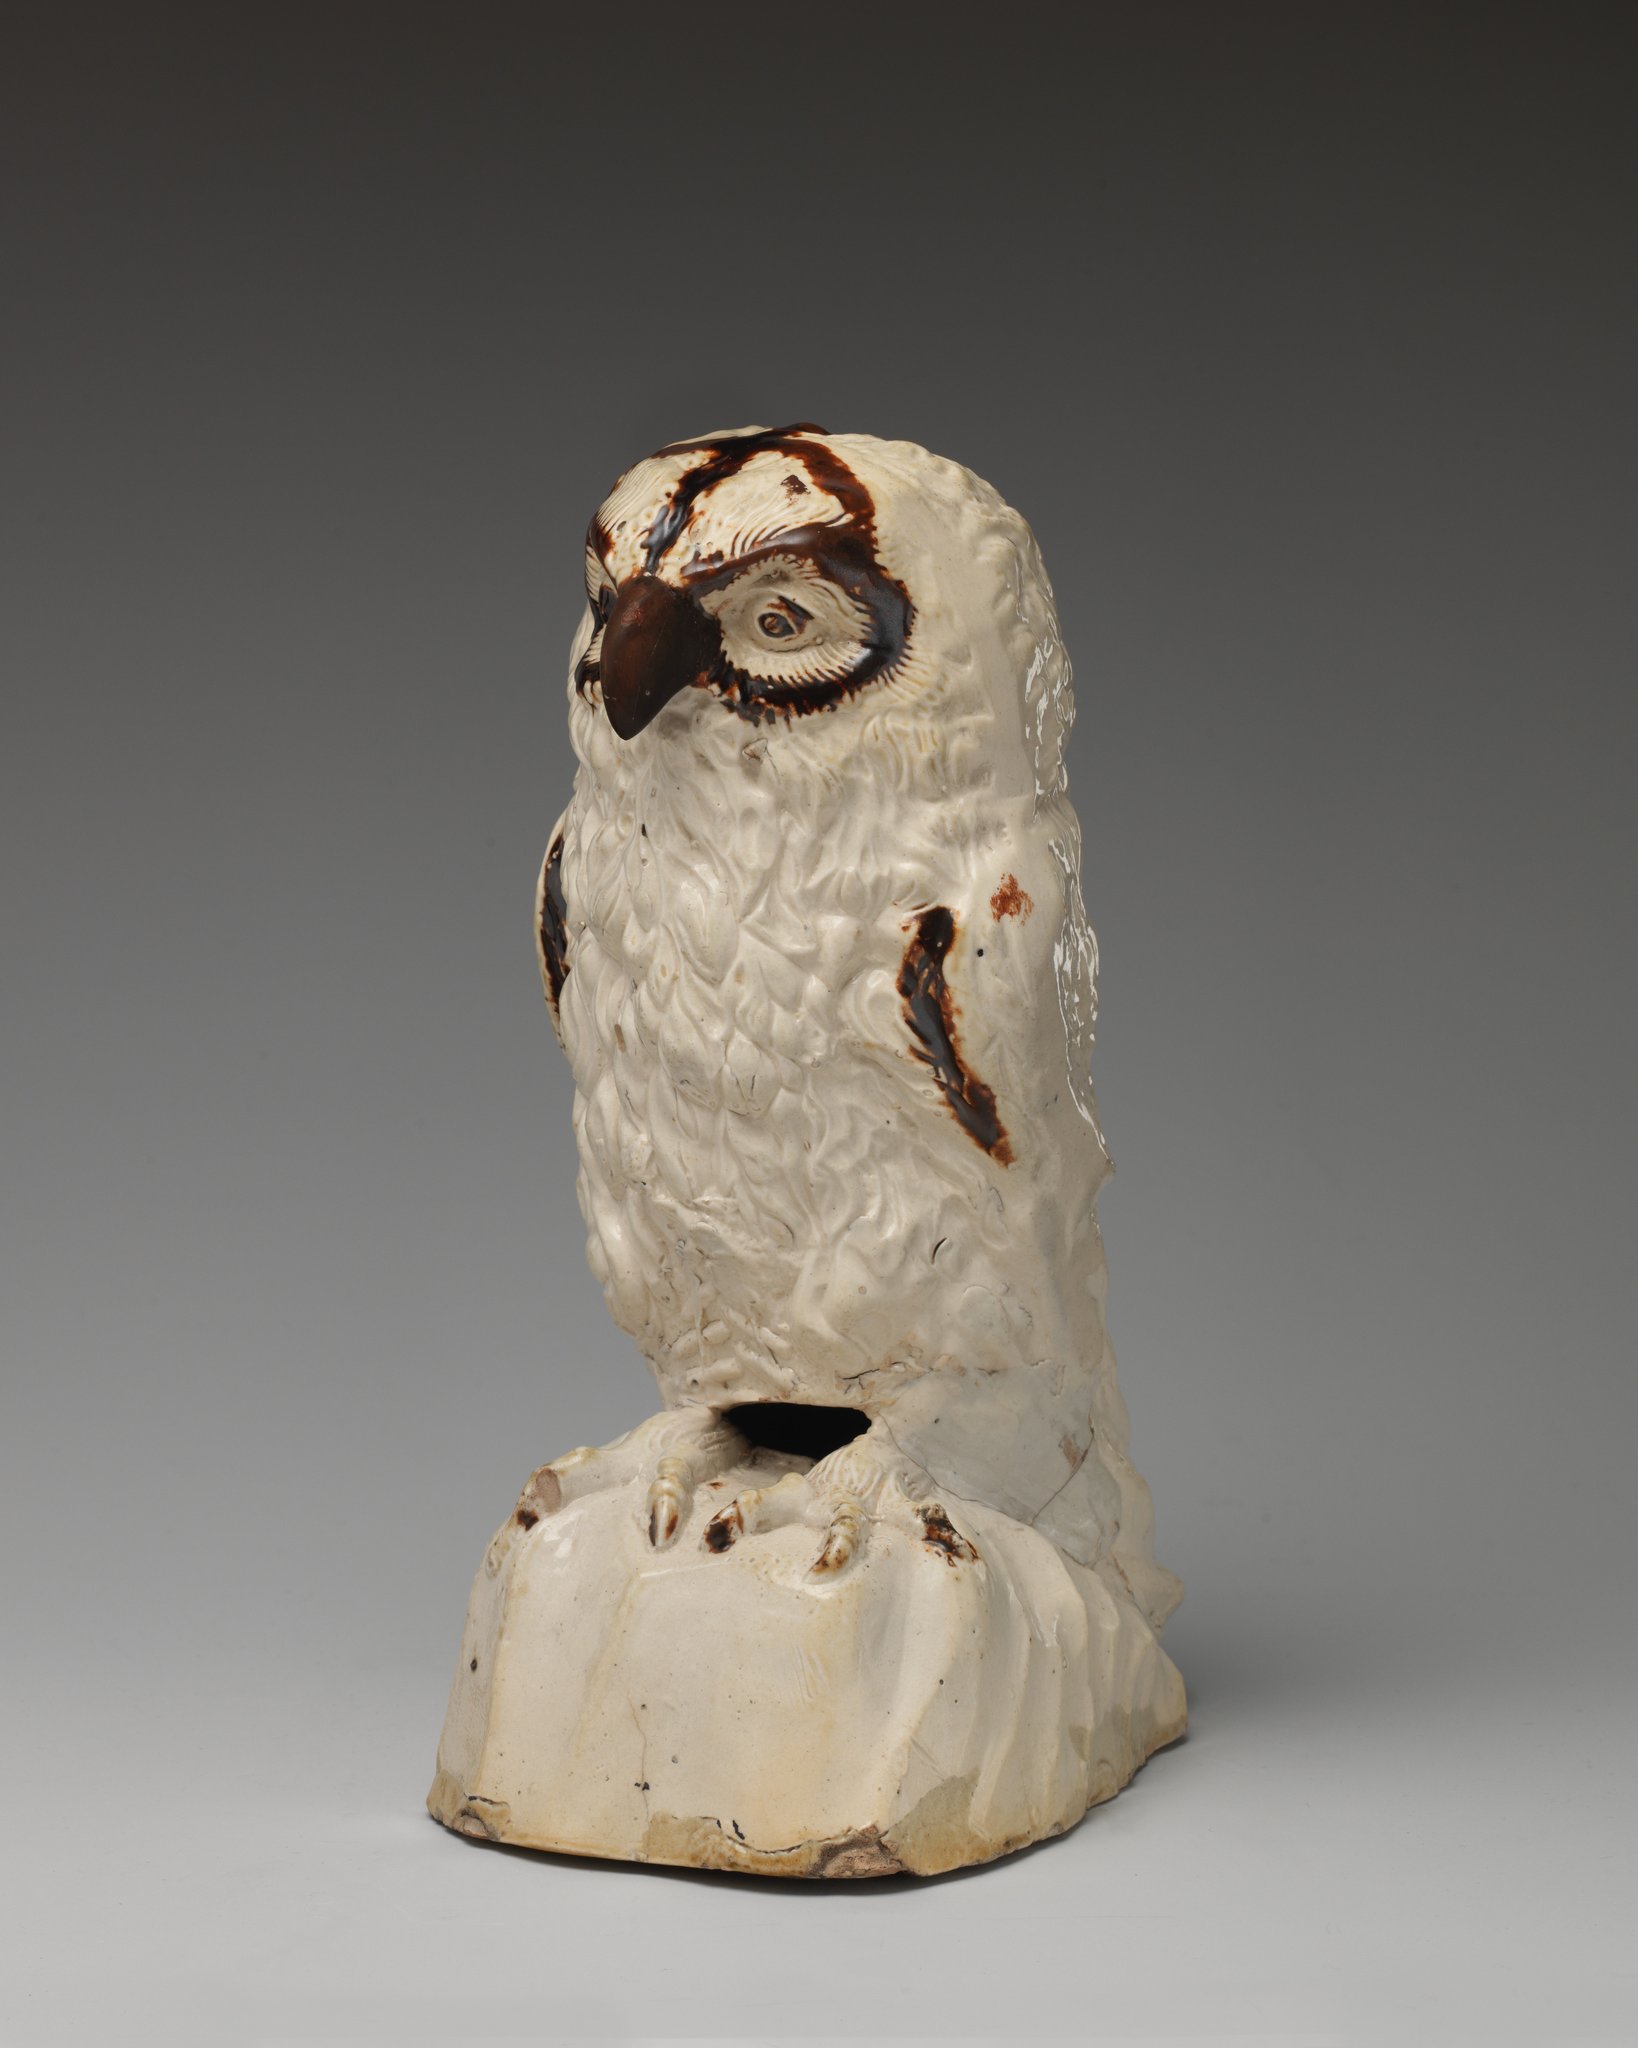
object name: figure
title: Owl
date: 1750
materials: stoneware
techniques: salt glaze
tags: owls